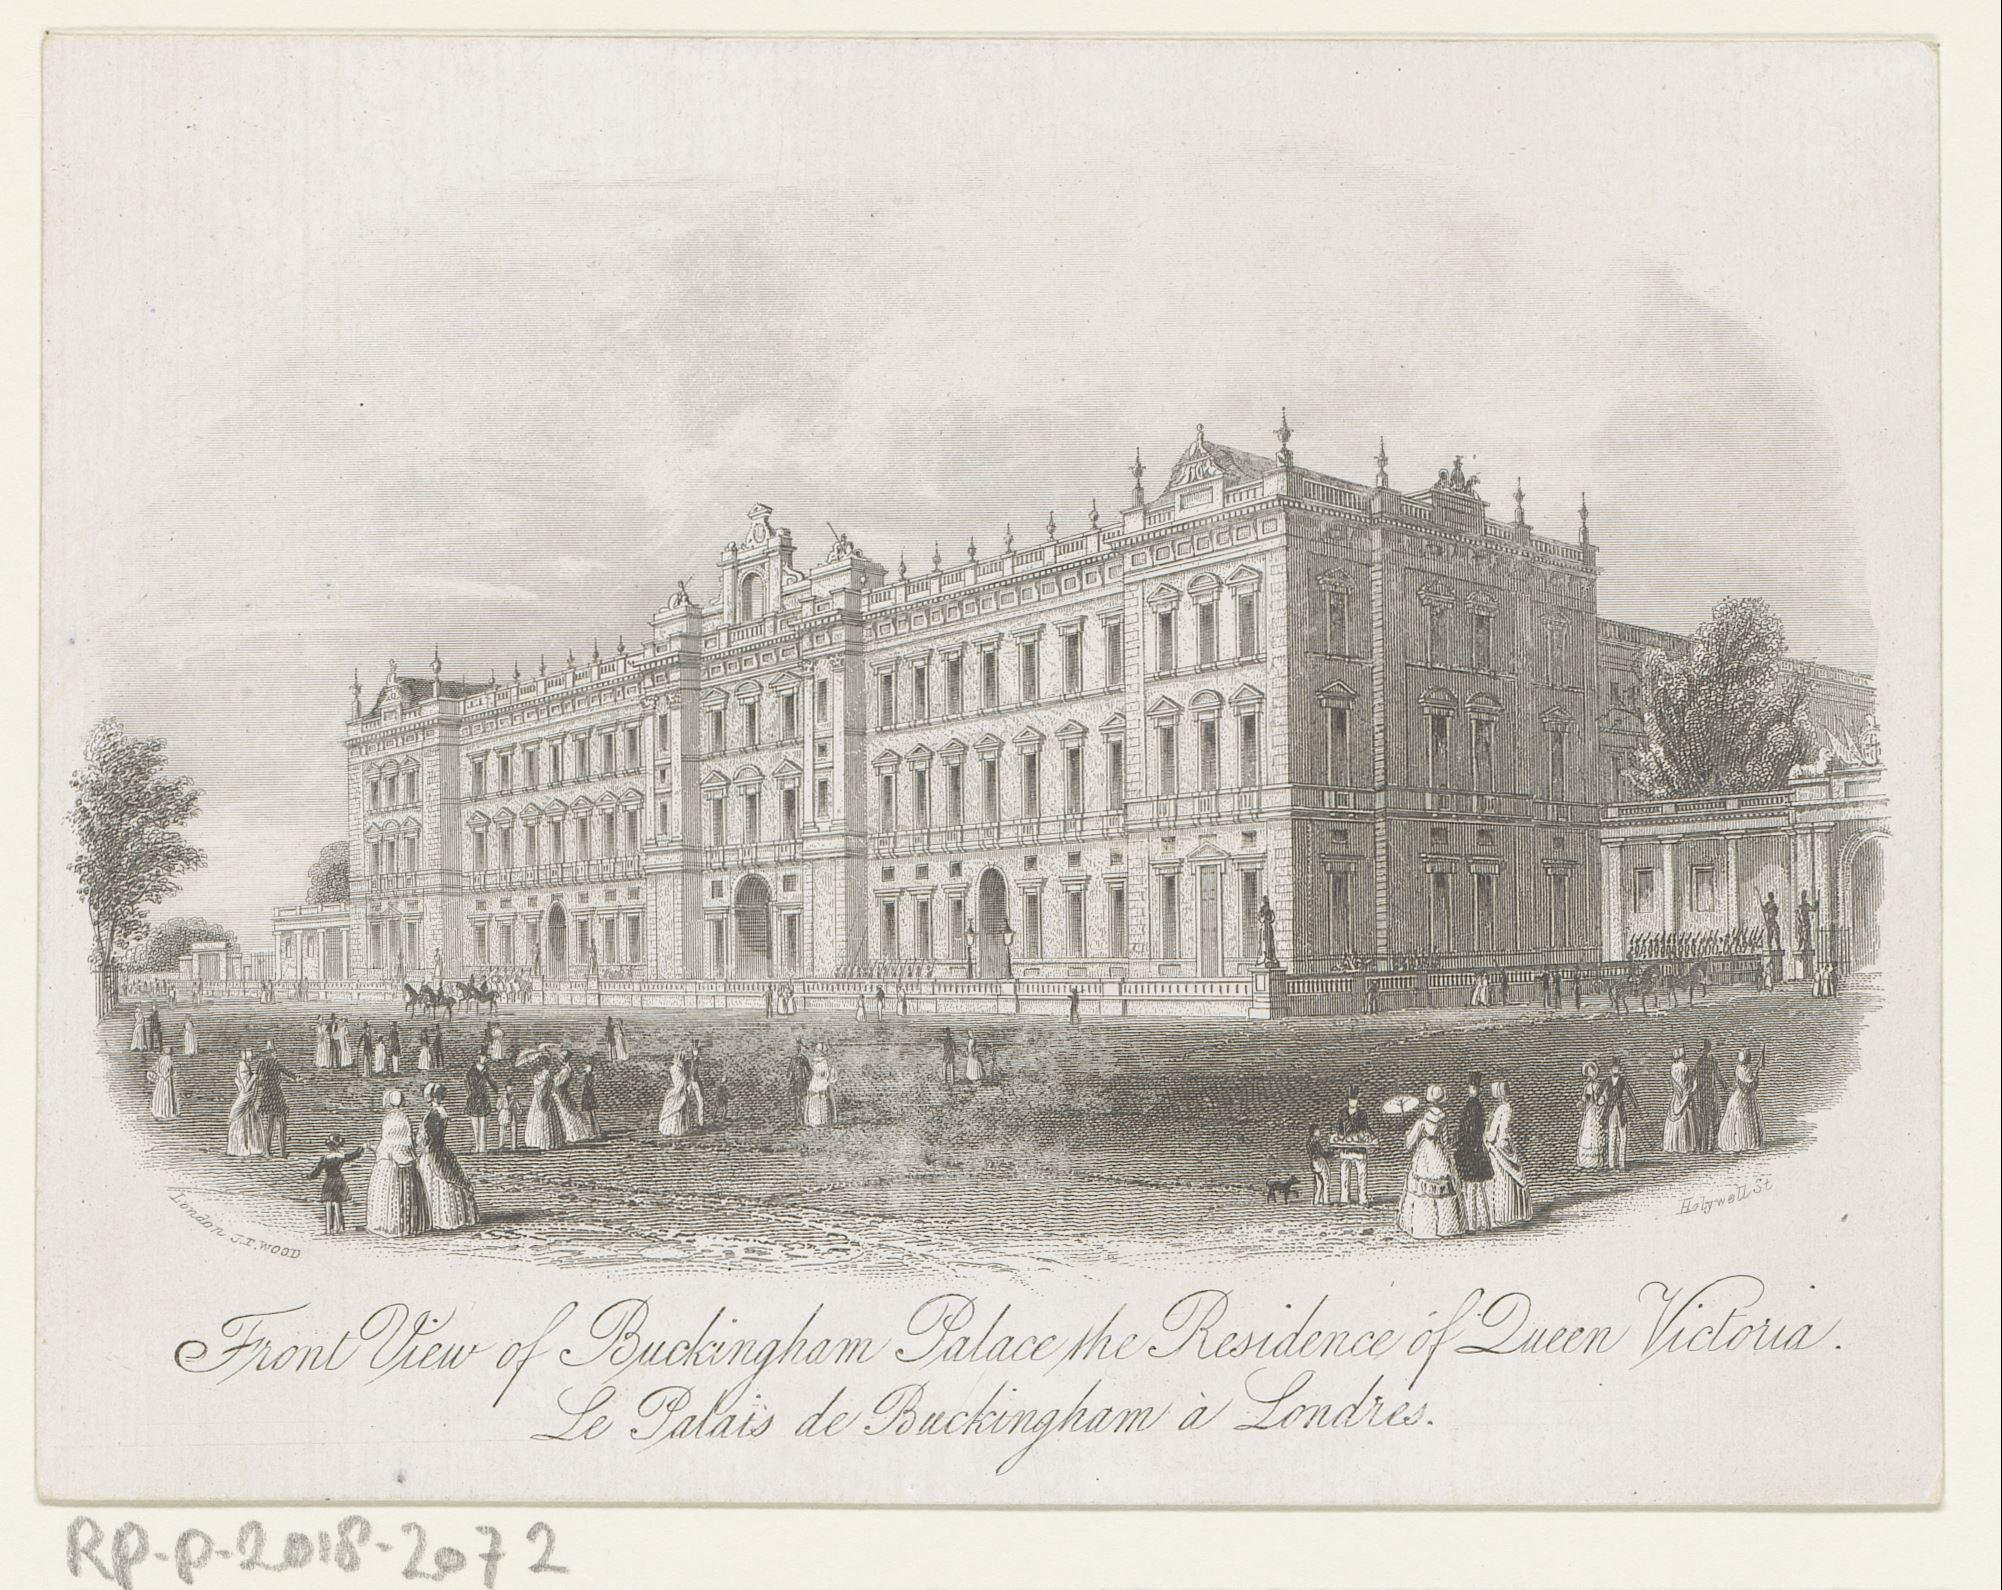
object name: print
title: Front view of Buckingham Palace the residence of Queen Victoria / Le Palais de Buckingham à Londres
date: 1841-1885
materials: paper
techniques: etching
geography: london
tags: palace